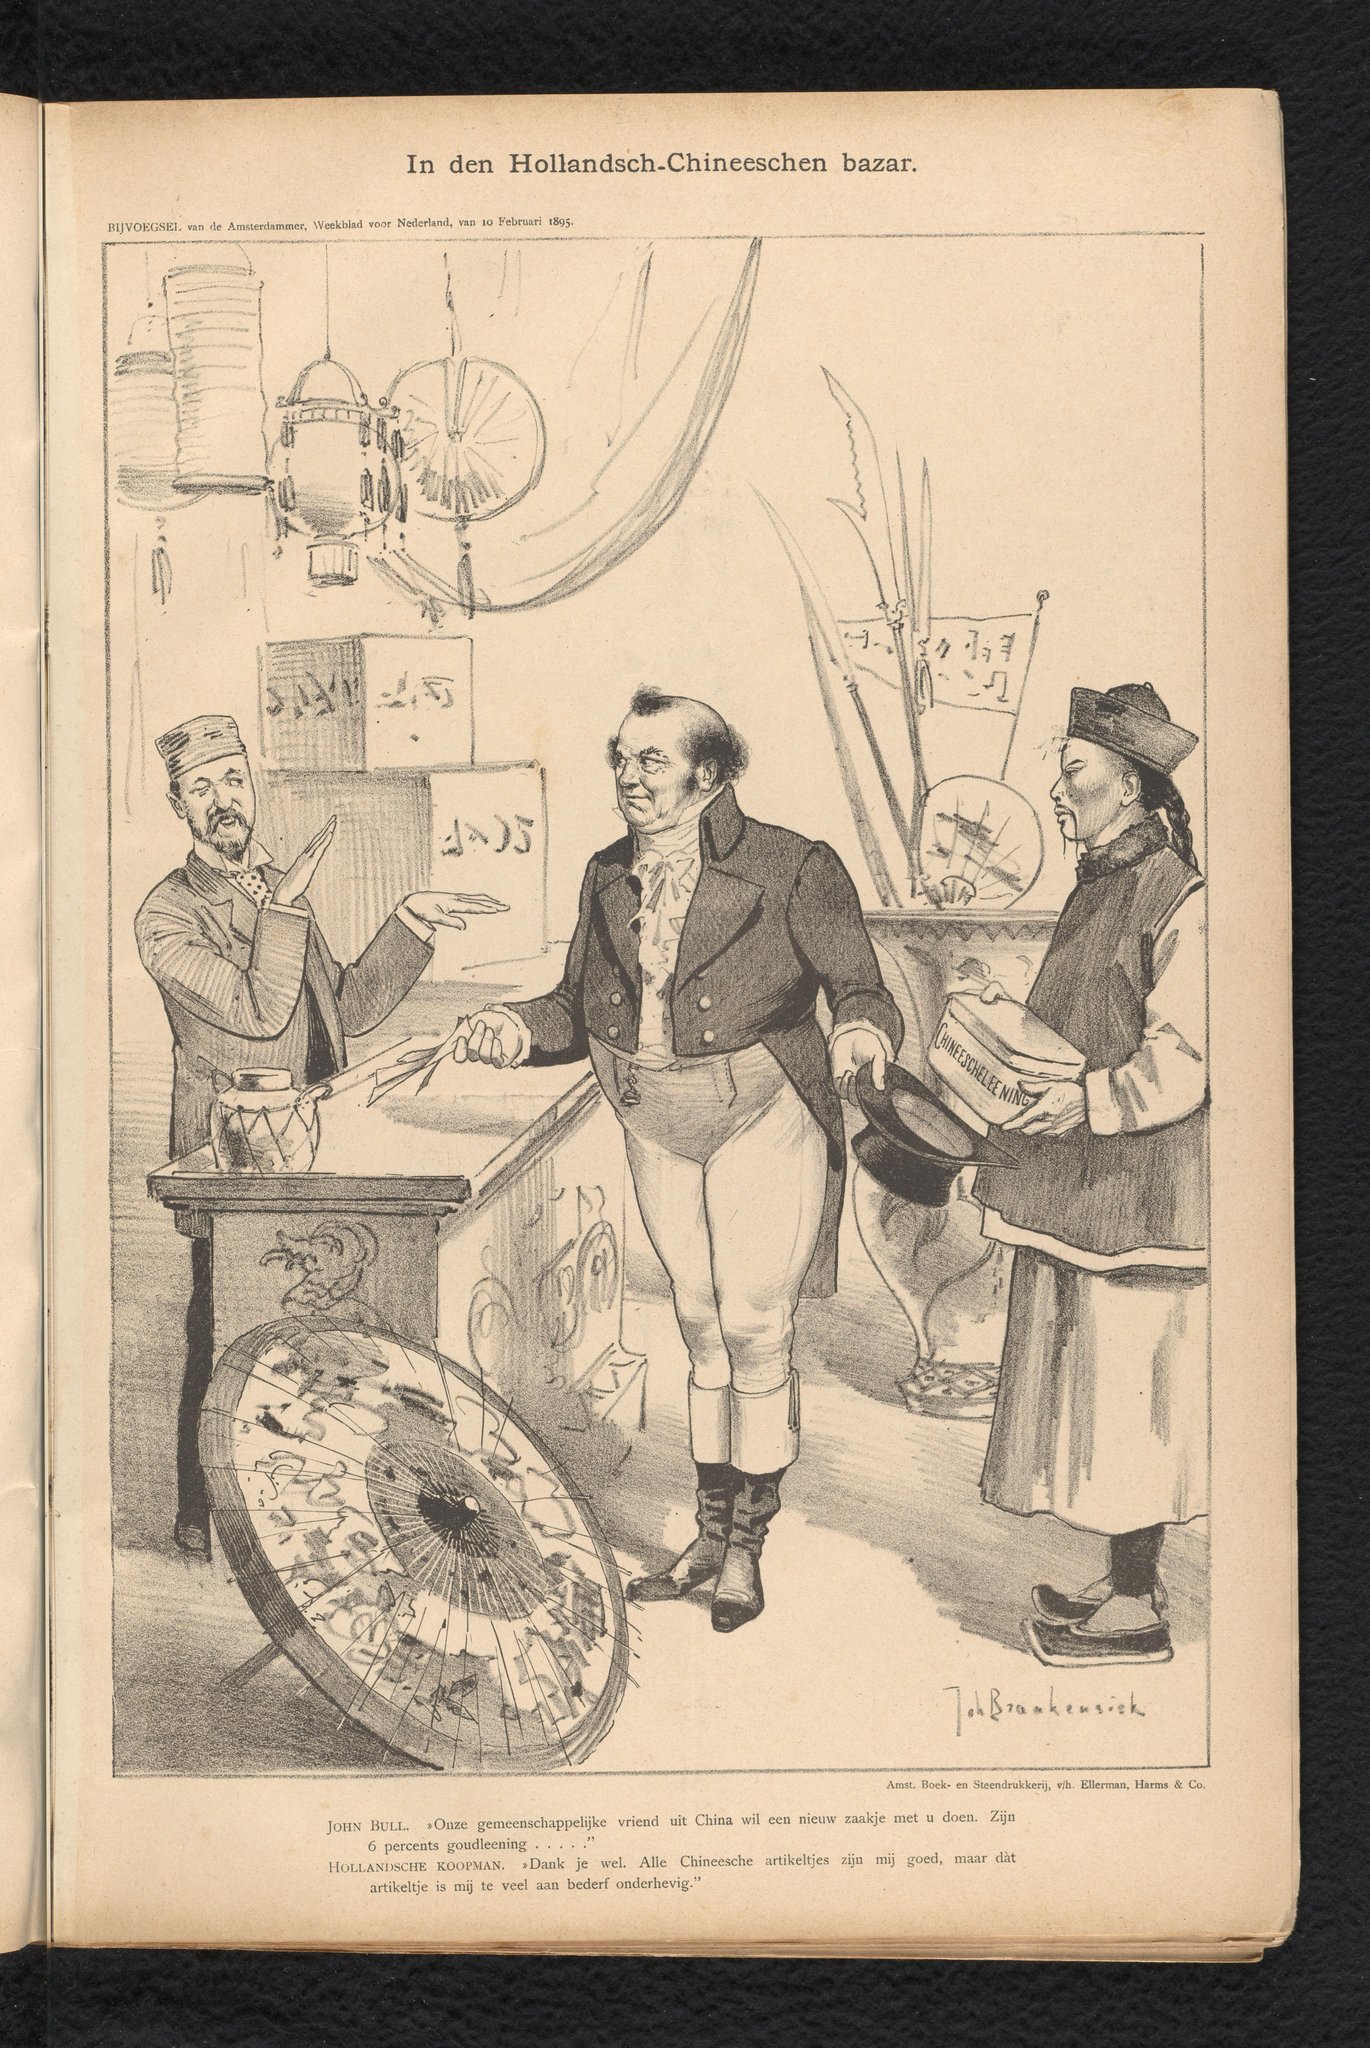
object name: cartoon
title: In den Hollandsch-Chineeschen bazar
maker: johan braakensiek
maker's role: draughtsman, print maker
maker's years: 1858-1940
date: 1895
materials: paper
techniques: lithograph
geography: netherlands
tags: counter ~ shop, personifications of countries, nations, states, districts, etc., dealing in money, political caricatures and satires, china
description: John Bull (Engeland) nodigt de Nederlandse winkelier de 'Hollandsche Koopman' uit om zaken te doen met zijn Chinese vriend die een lening wil afsluiten.